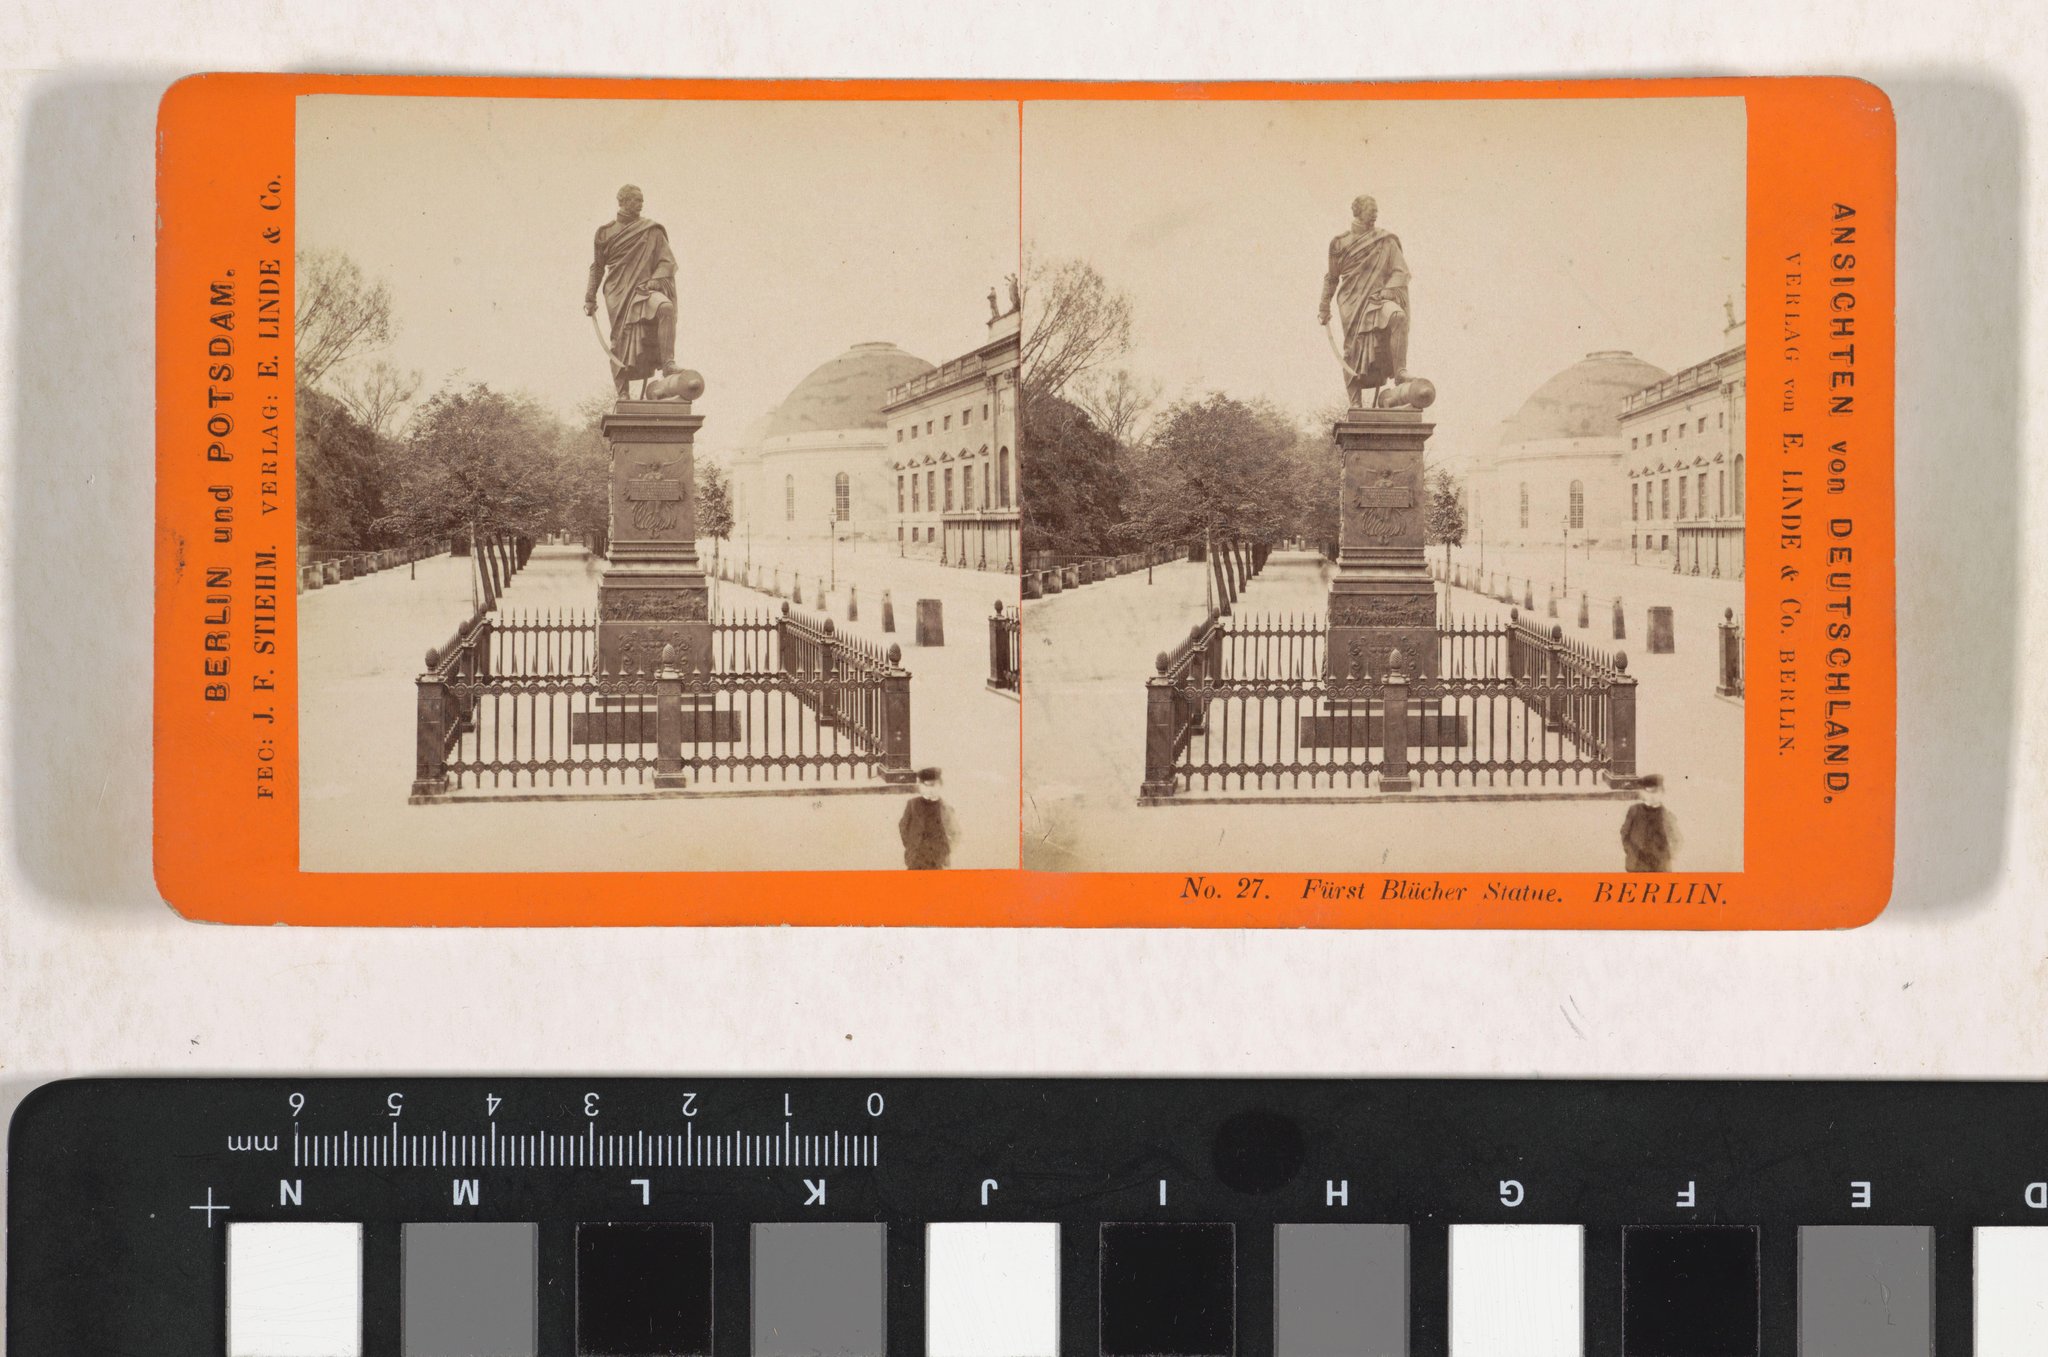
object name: stereograph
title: Fürst Blücher Statue. Berlin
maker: johann friedrich stiehm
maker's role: fotograaf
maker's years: 1826-1902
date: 1868-1870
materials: cardboard, paper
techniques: albumen print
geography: berlin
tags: monument, statue, berlin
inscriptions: number: ‘No. 27.’